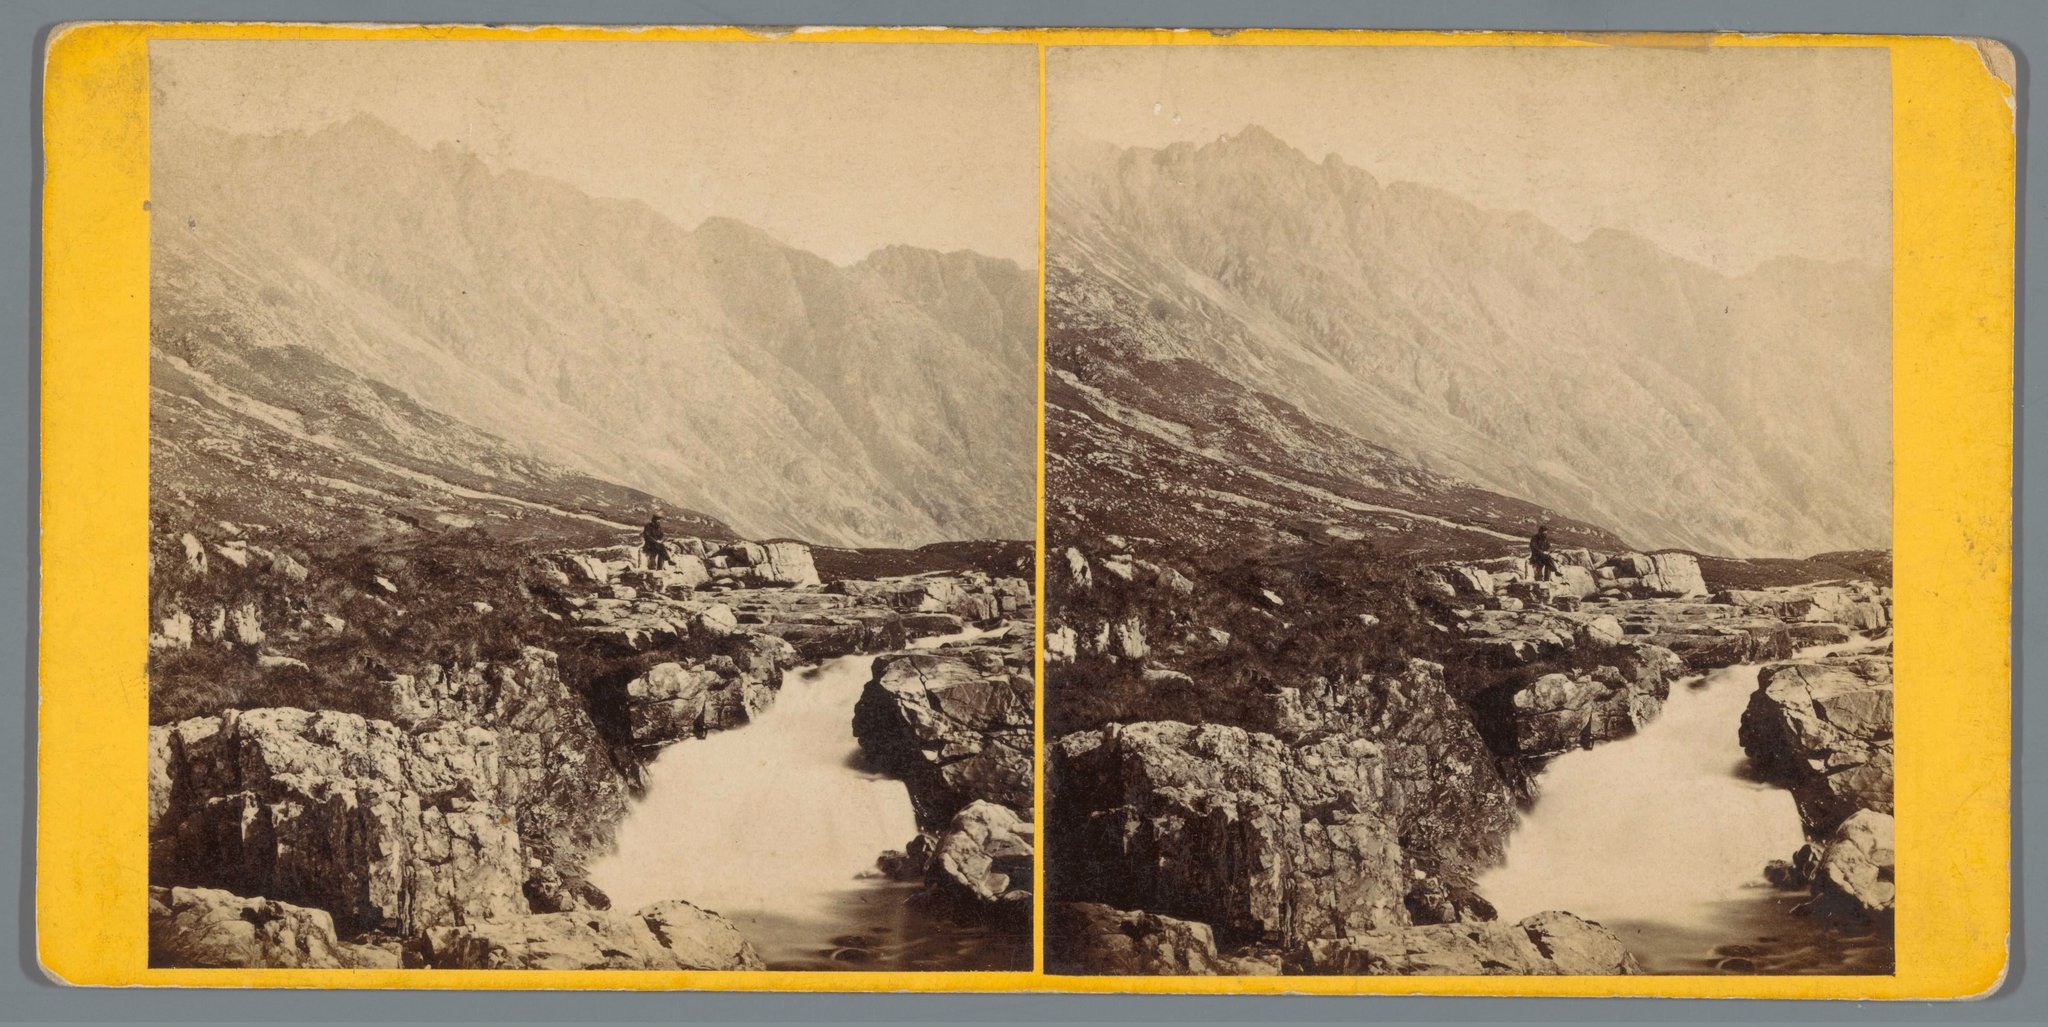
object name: stereograph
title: Looking up Glencoe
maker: george washington wilson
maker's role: publisher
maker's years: 1823-1893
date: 1860-1865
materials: cardboard, photographic support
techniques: albumen print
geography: aberdeen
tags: schotland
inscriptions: label: ‘G.W. Wilson & Co, Aberdeen No. 150 Looking up Glencoe’